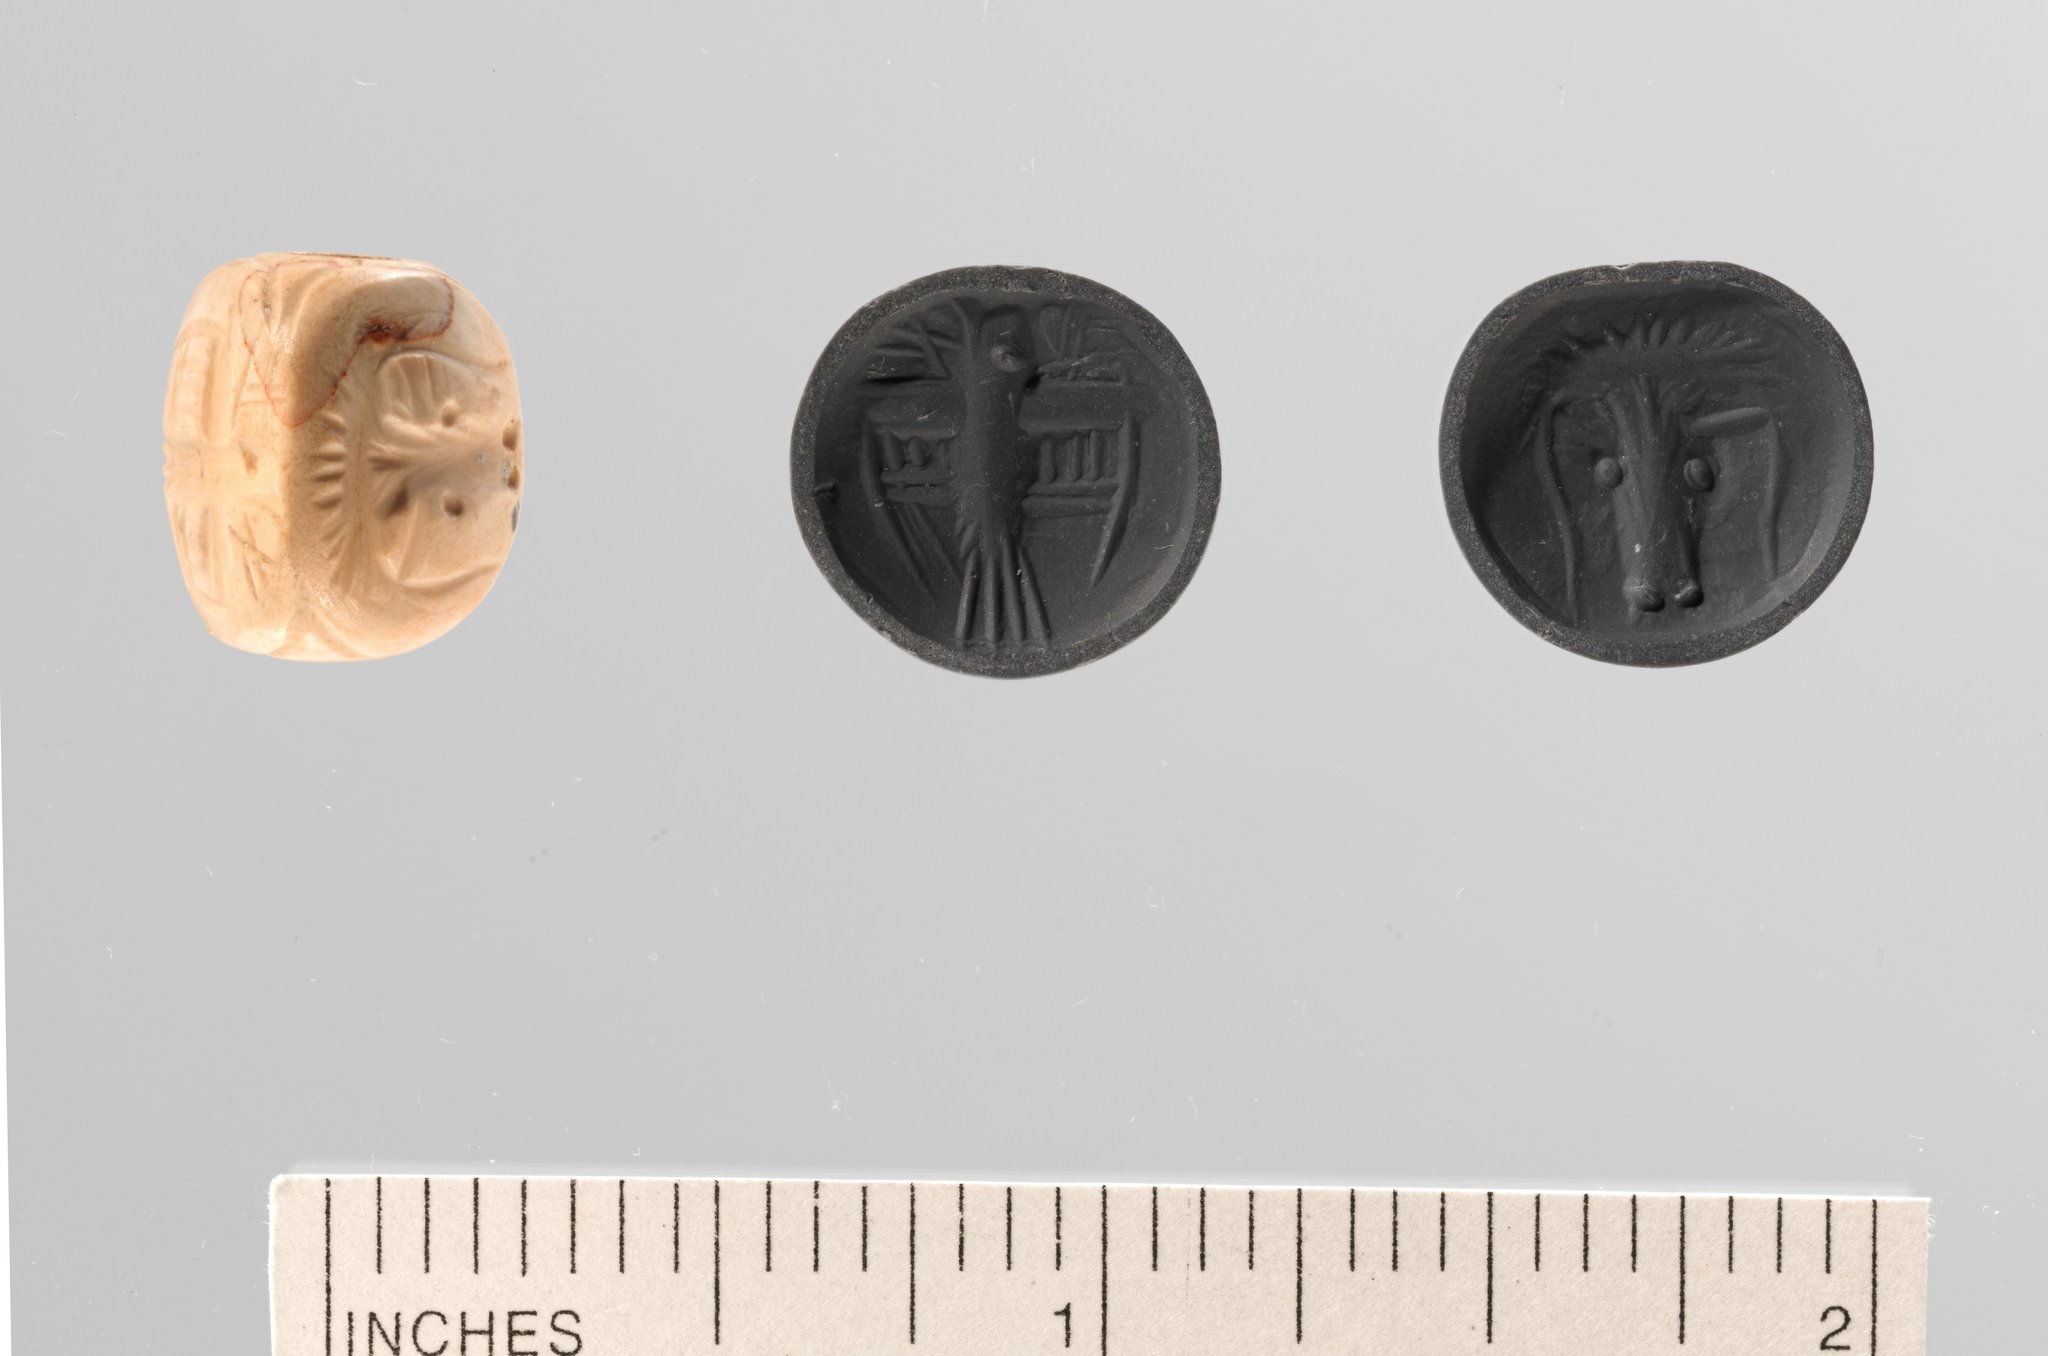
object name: prism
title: Carnelian Prism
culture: minoan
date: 1650-1500 BCE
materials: gemstone